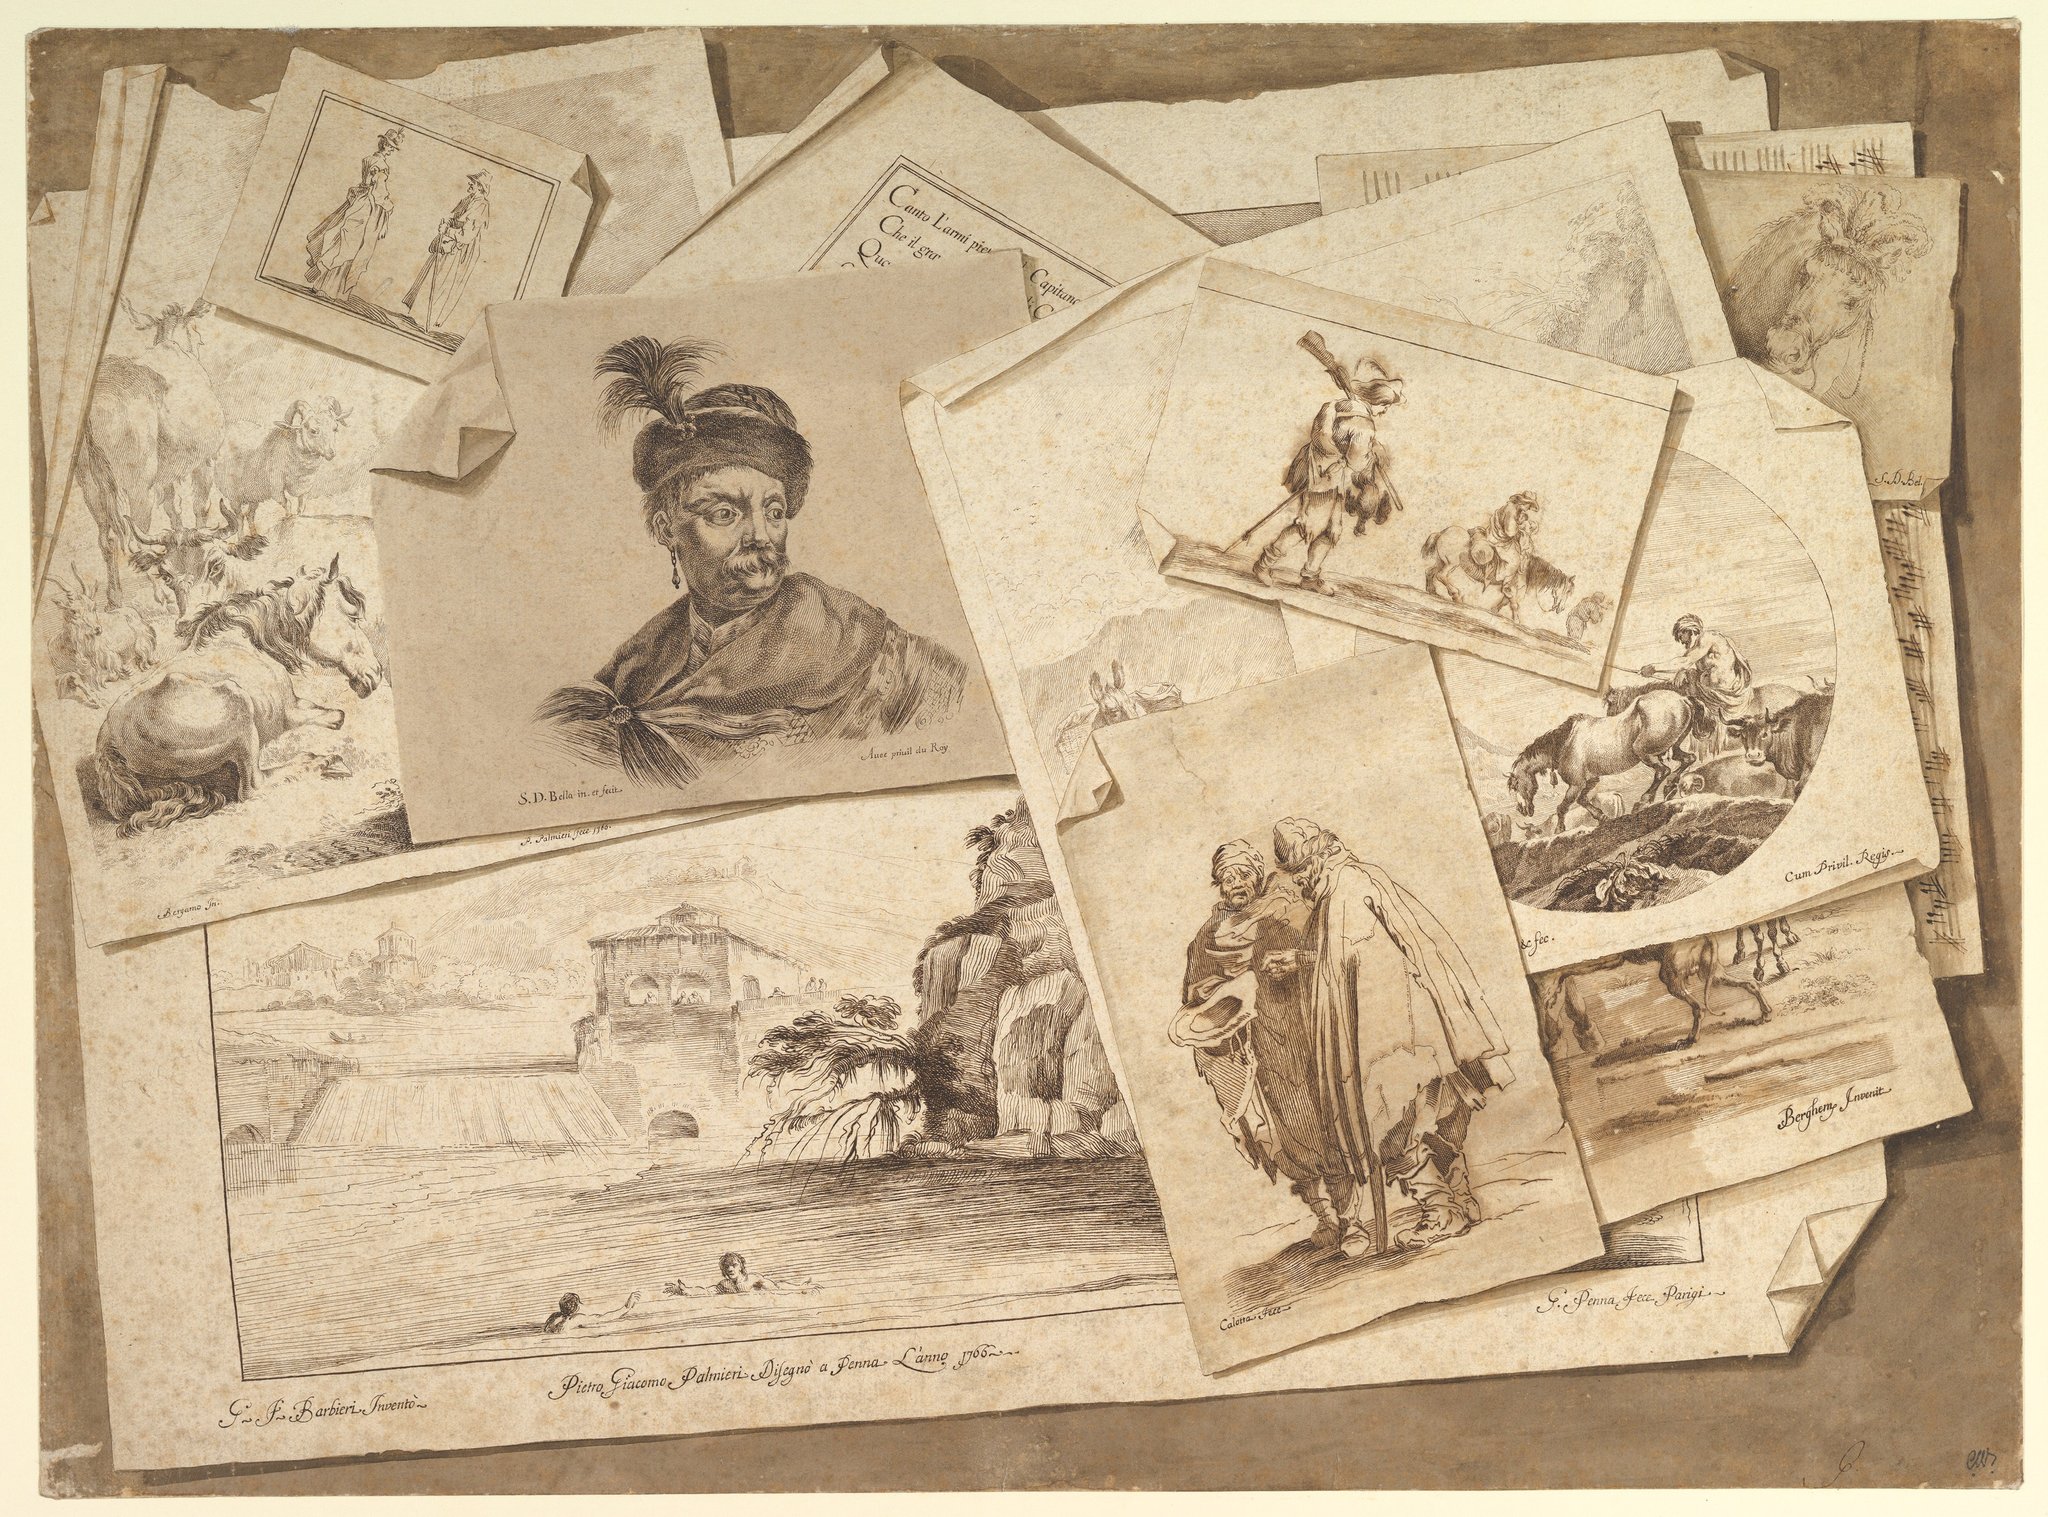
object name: drawing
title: Trompe-l'Oeil Exercise: Prints on a Table Top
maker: pietro jacopo palmieri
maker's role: artist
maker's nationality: italian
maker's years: 1737-1804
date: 1766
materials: graphite, ink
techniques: brush, pen, wash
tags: men,women,horses,trompe-l'oeil